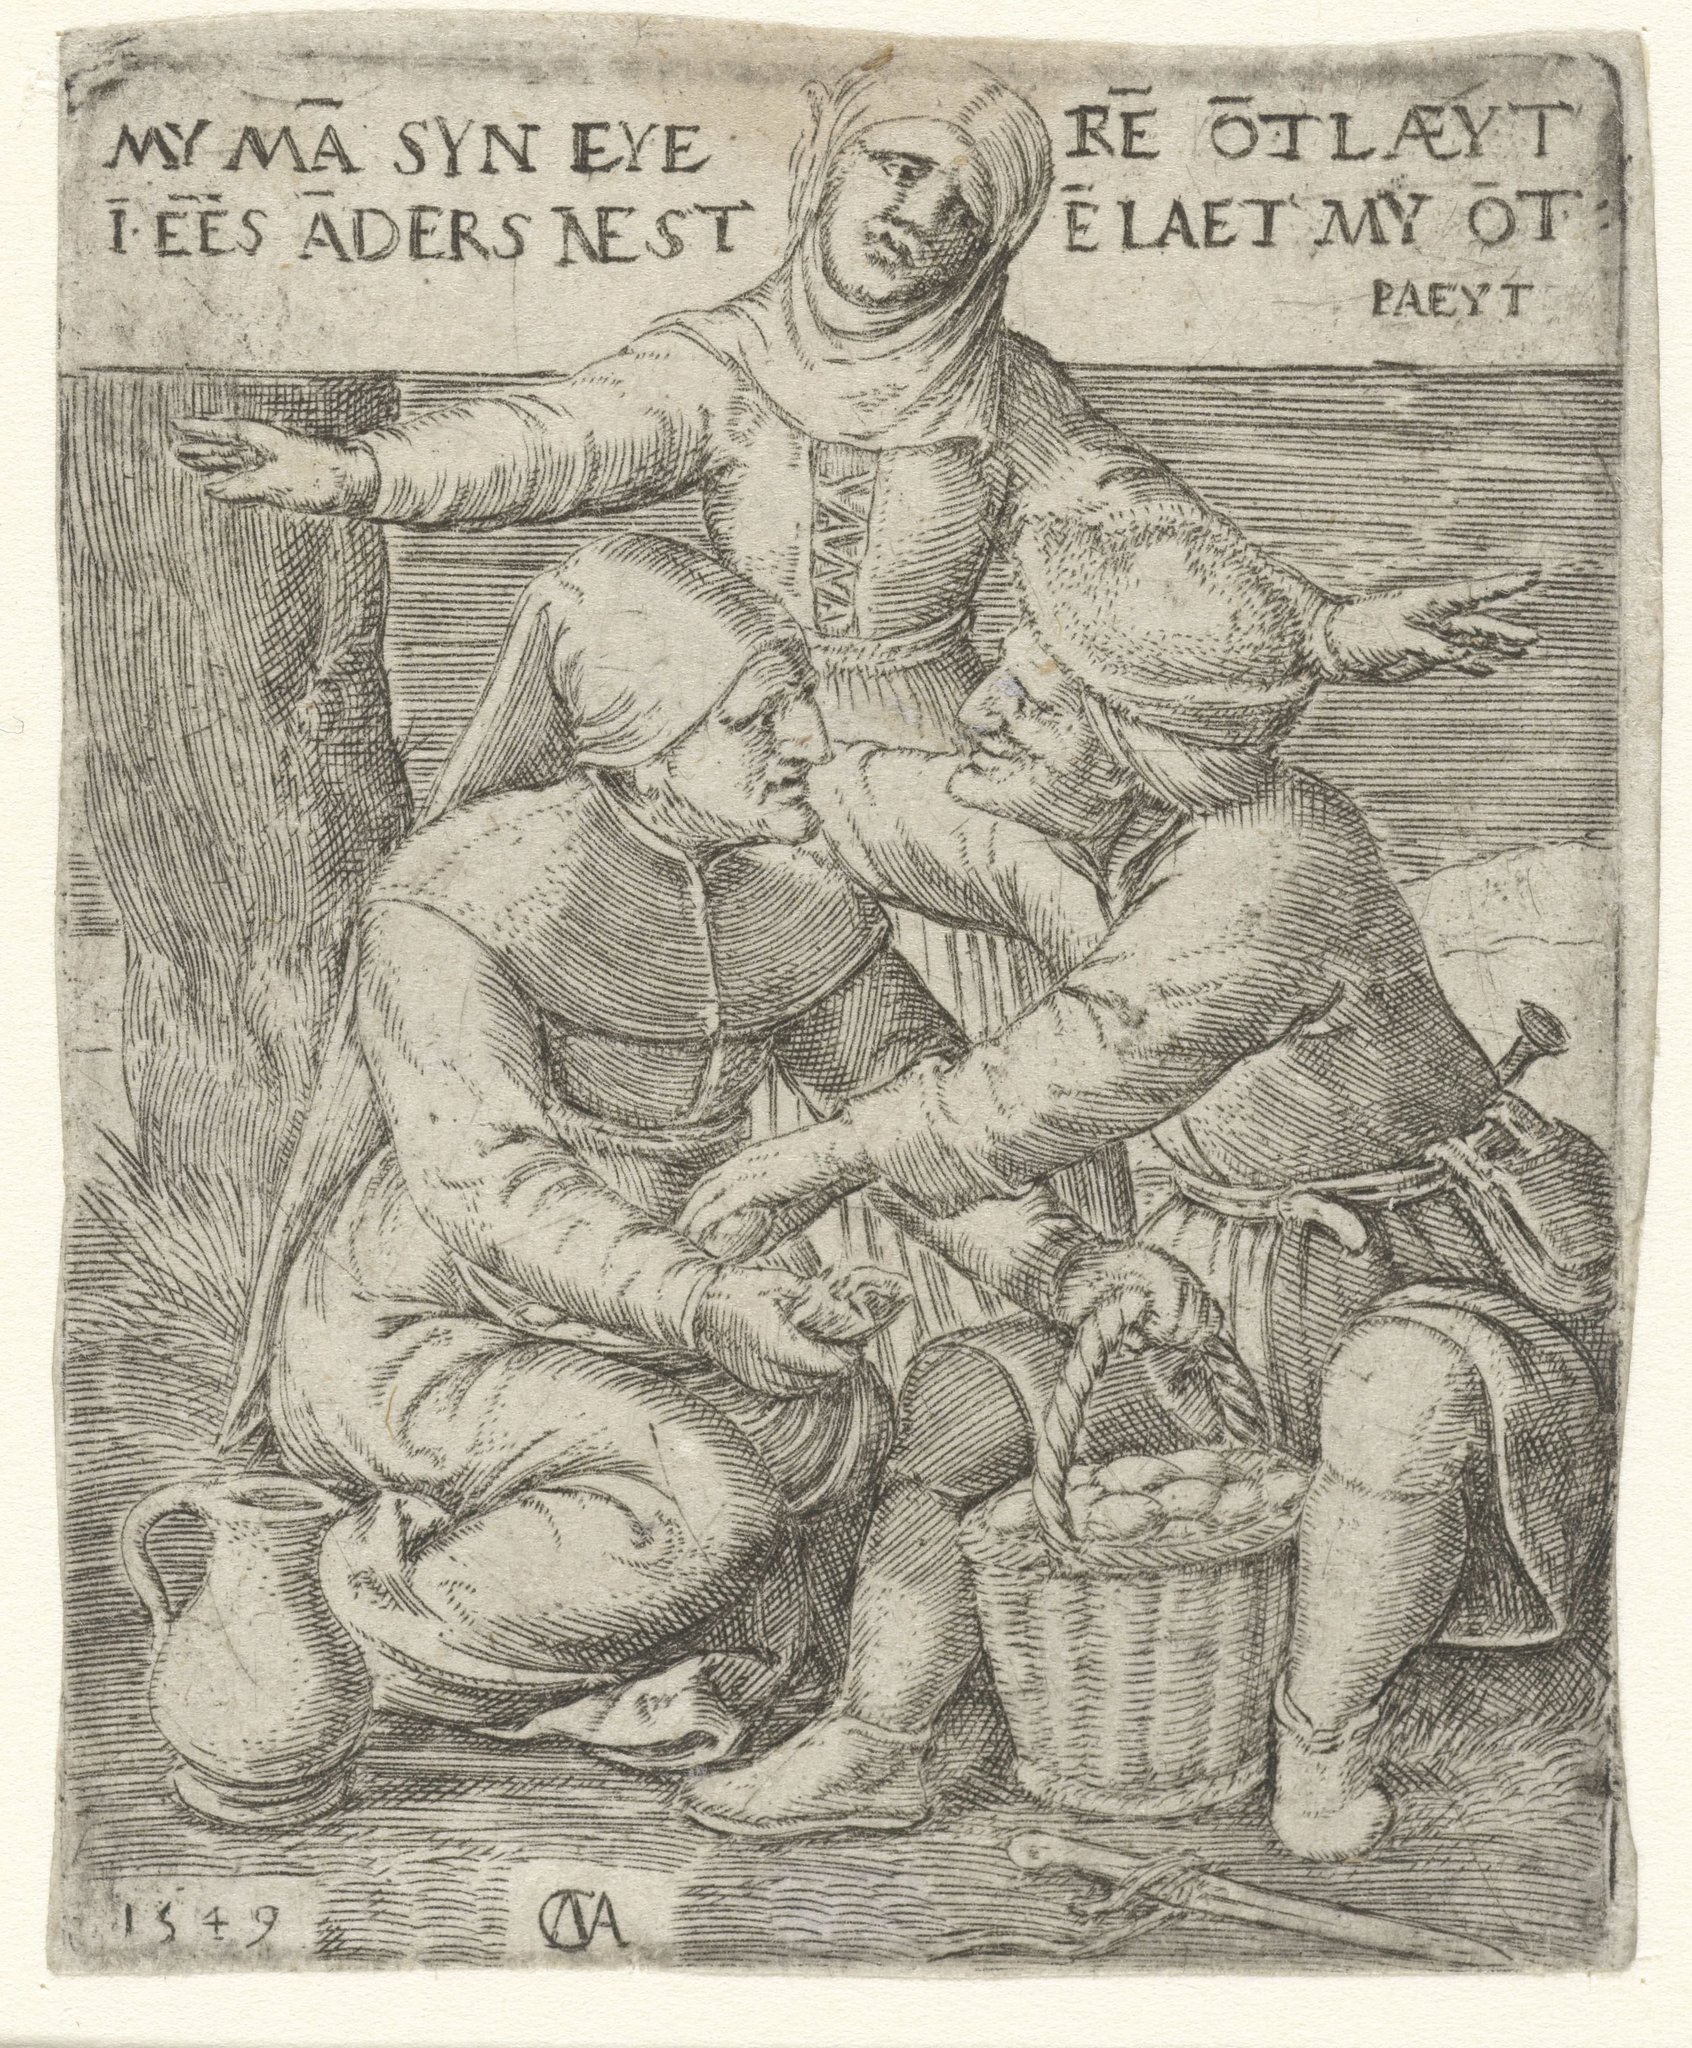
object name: print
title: Allegorie op overspel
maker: cornelis massijs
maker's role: painter, print maker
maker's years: 1510-1557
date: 1549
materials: paper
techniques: engraving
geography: antwerp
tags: farmers, adultery, eggs, egg-dishes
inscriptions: collector's mark: Lugt 2227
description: Een vrouw betrapt haar man op overspel. De man legt een ei in de schoot van de vrouw naast hem, die meteen zijn mand met eieren pakt. Bovenaan de woorden van de vrouw in het Nederlands, waarin zij zegt dat haar man zijn eieren achterlaat in een ander nest, terwijl zij zonder achterblijft.